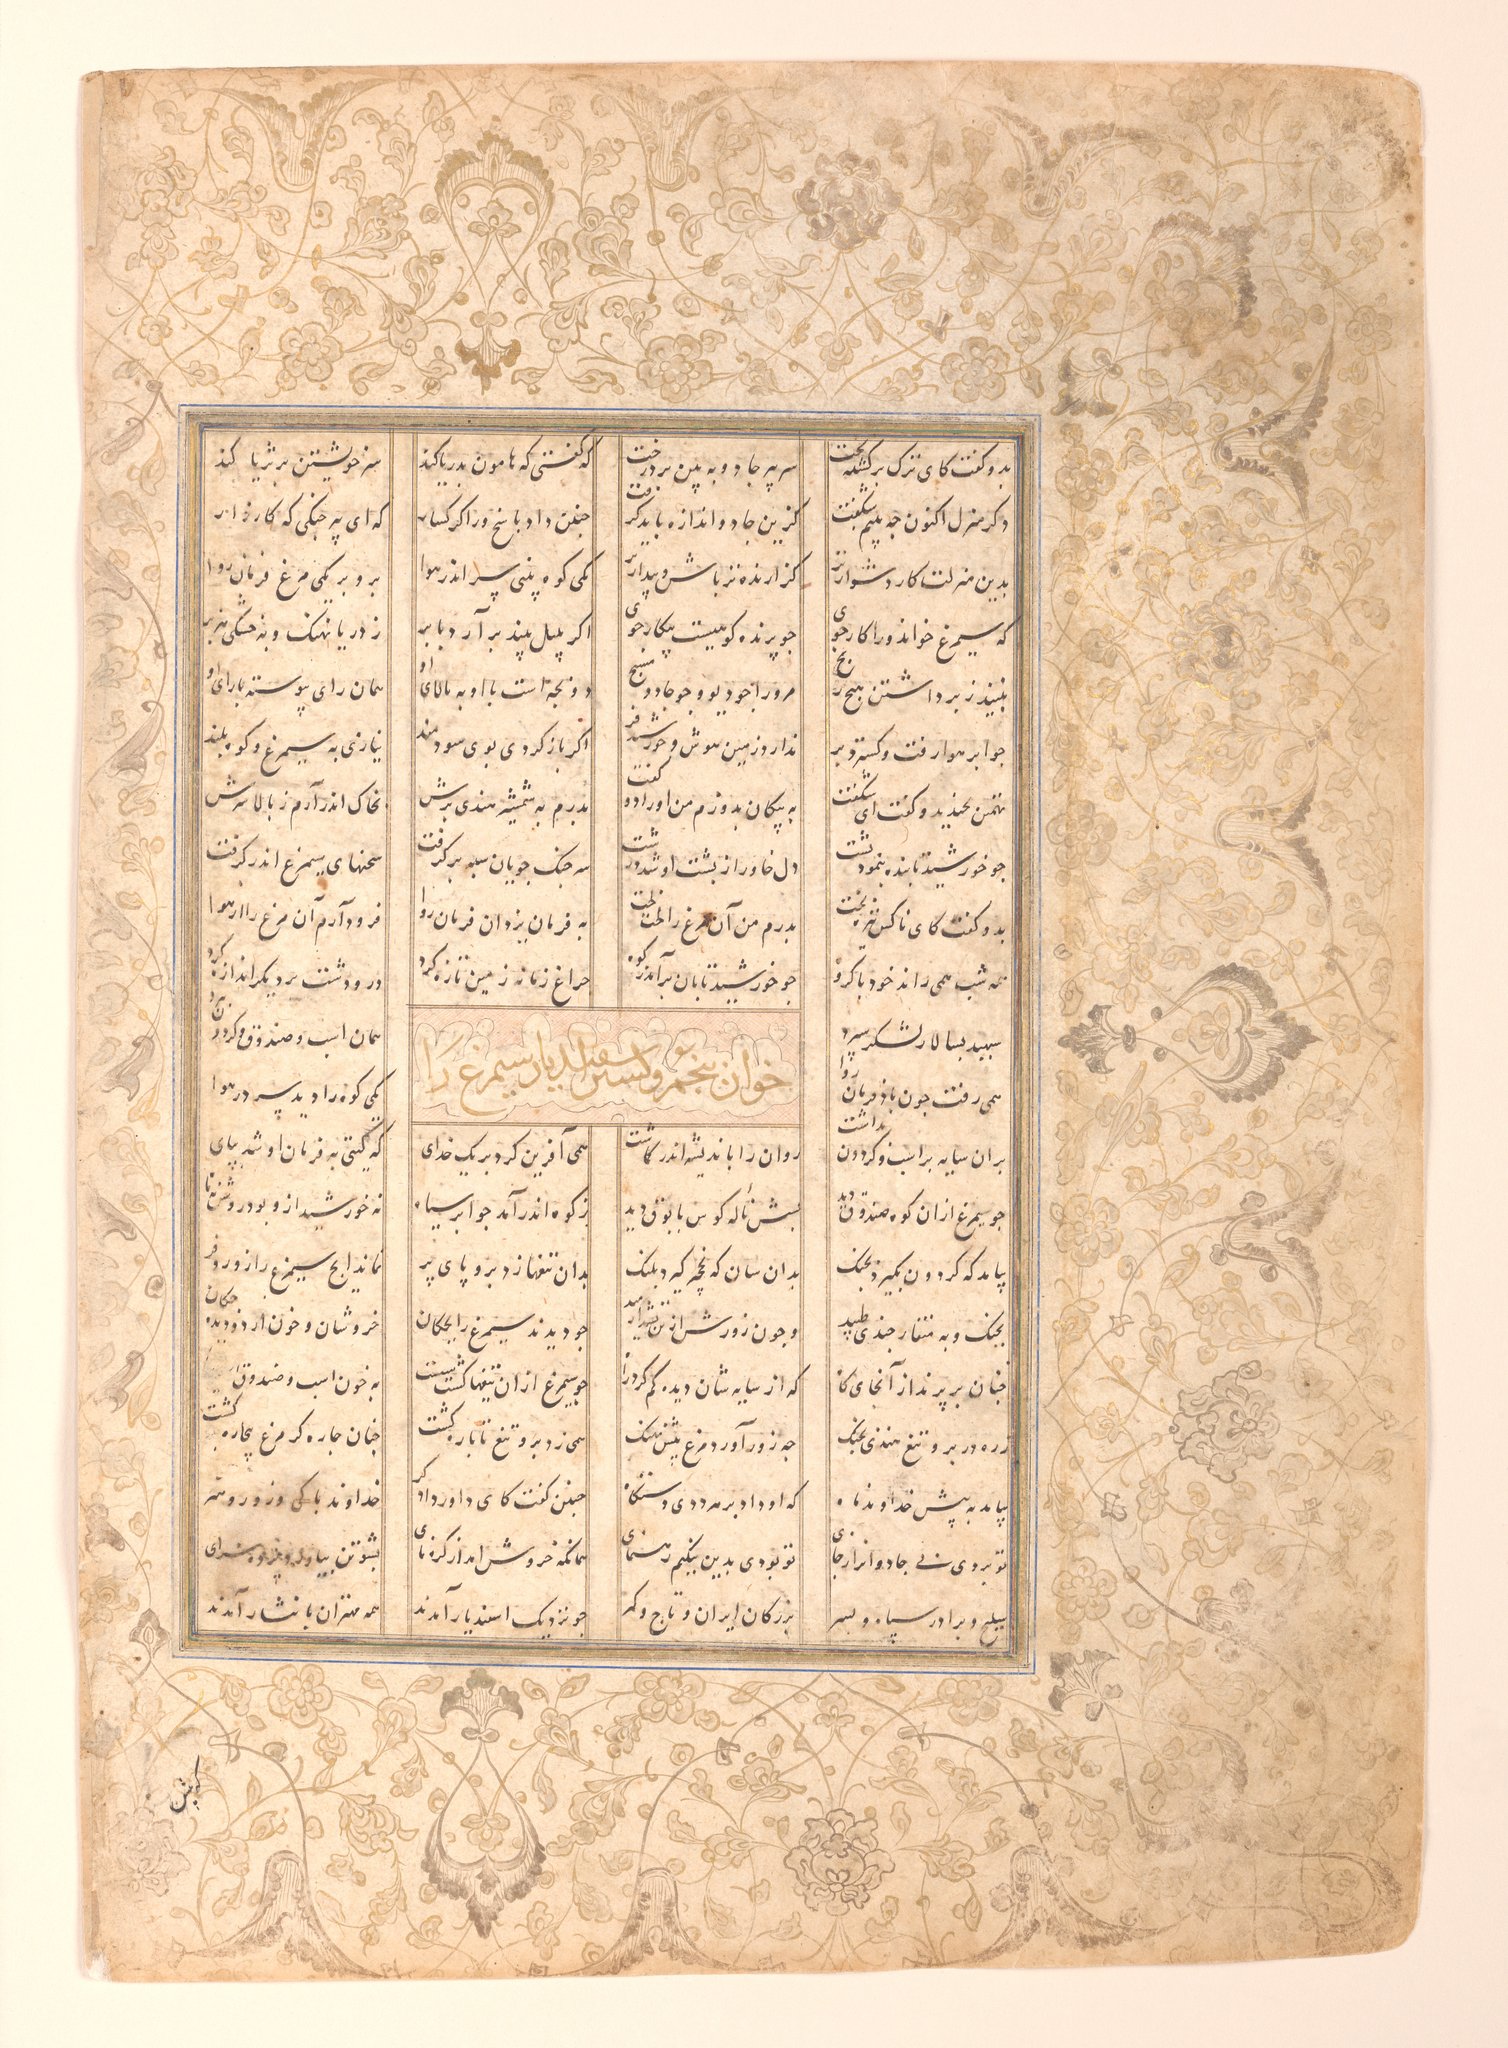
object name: folio from a non illustrated manuscript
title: "Fifth Joust, The Death of Simurgh by the Hands of Isfandiyar," Folio from a Shahnama (Book of Kings)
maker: abu'l qasim firdausi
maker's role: author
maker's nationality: iranian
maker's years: 935-1020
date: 1501-1600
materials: gold, ink, paint, paper, watercolor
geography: iran